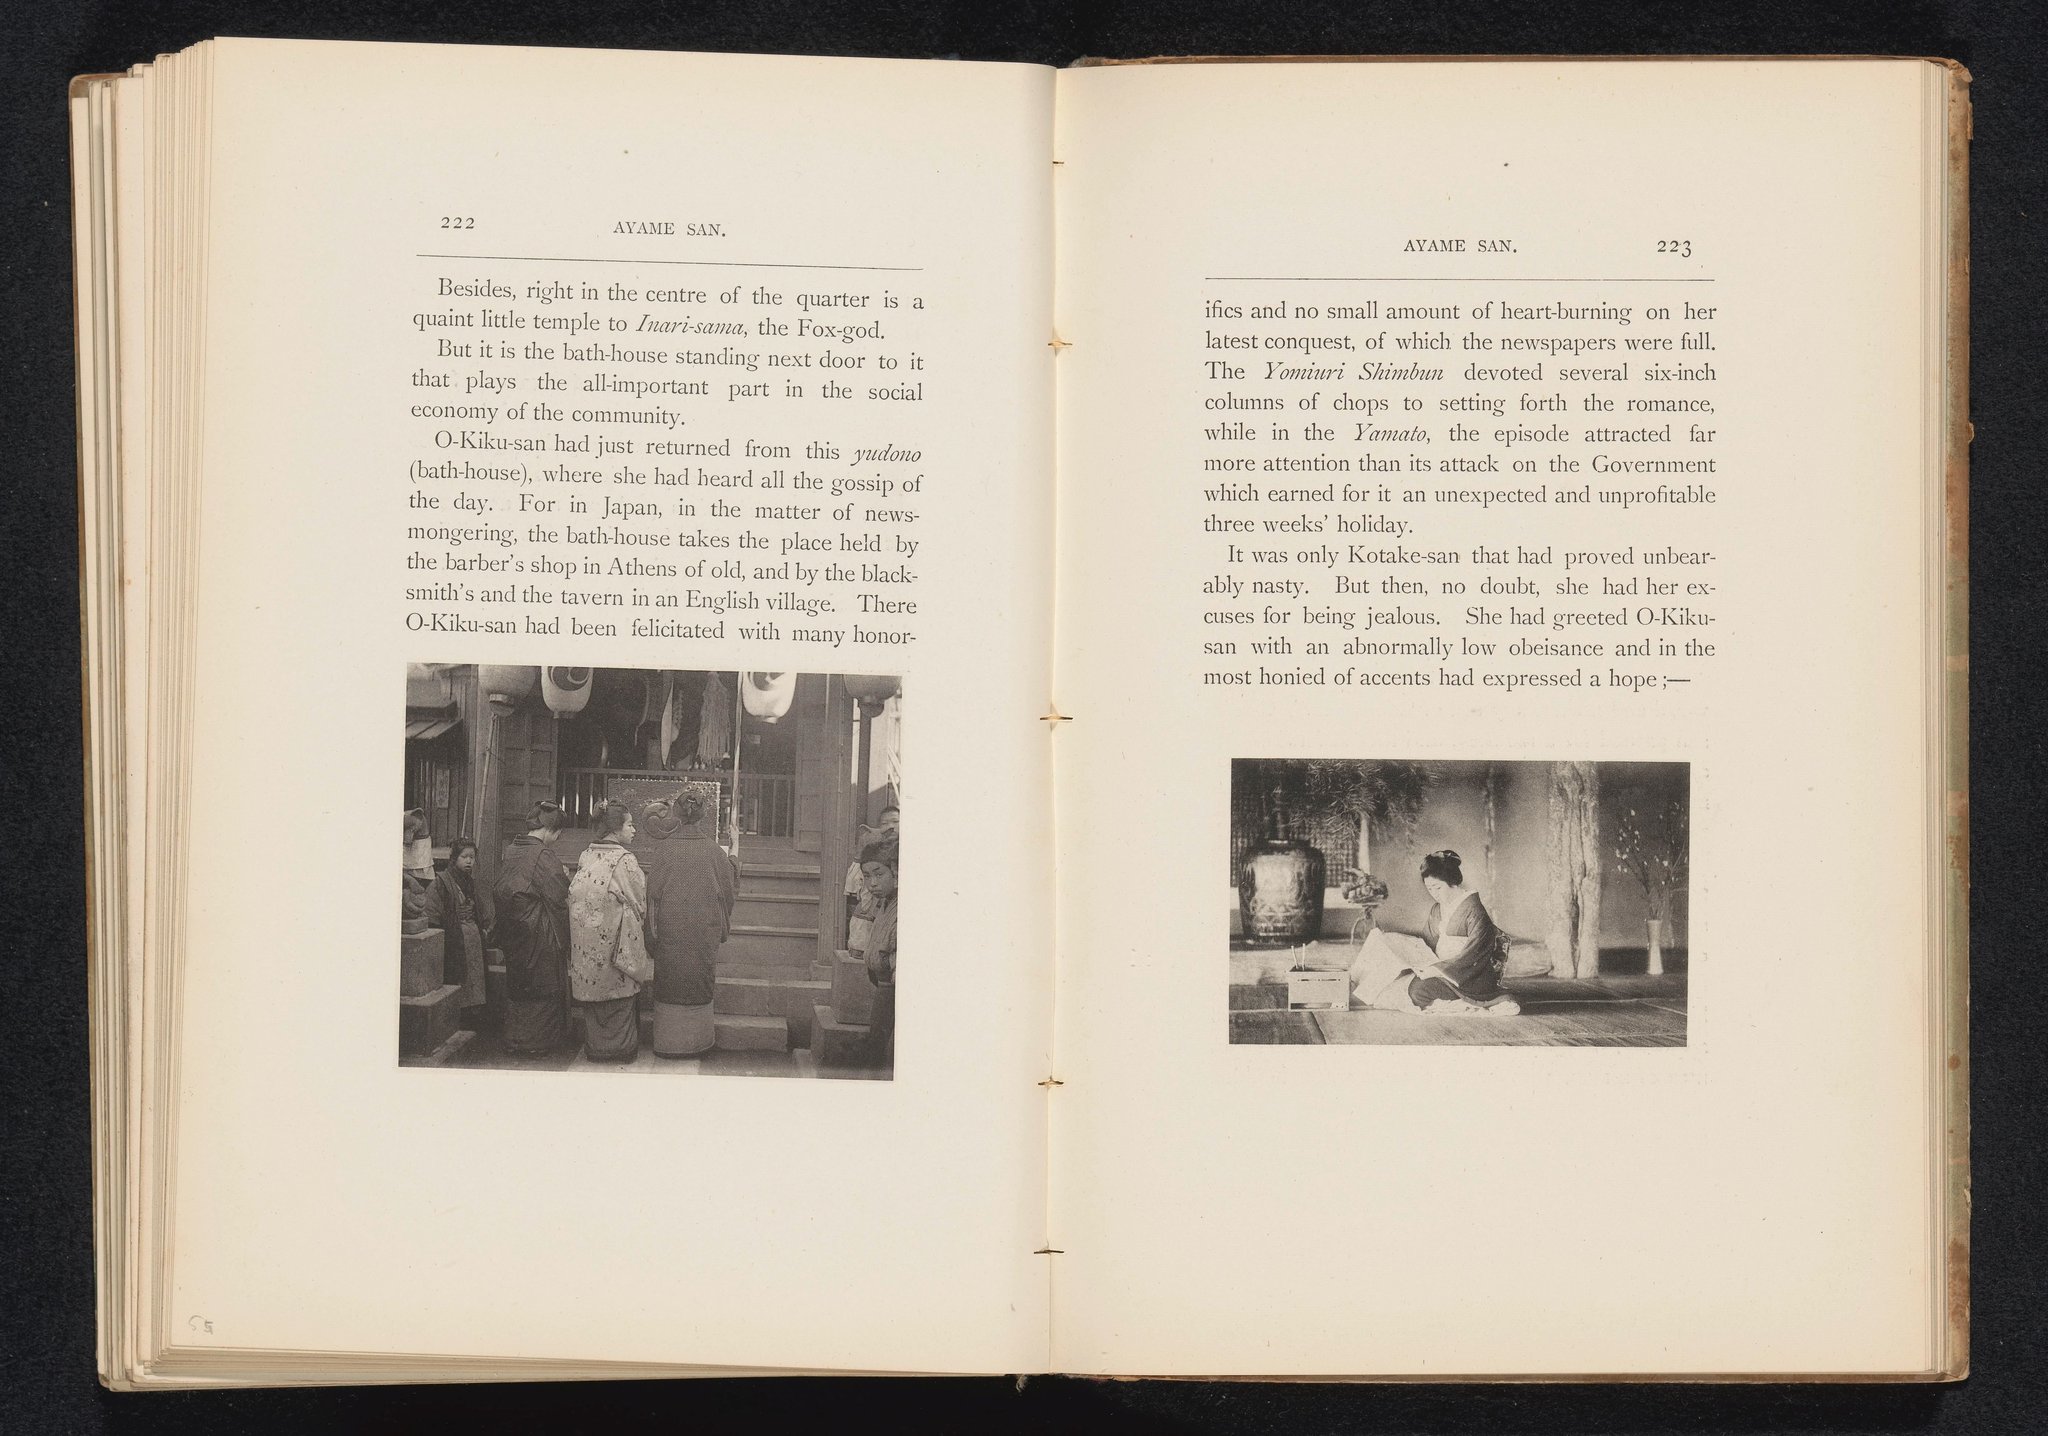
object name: page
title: Drie vrouwen voor een gebouw te Japan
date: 1882-1892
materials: paper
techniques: photograph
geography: japan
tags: adult woman, façade (of house or building)